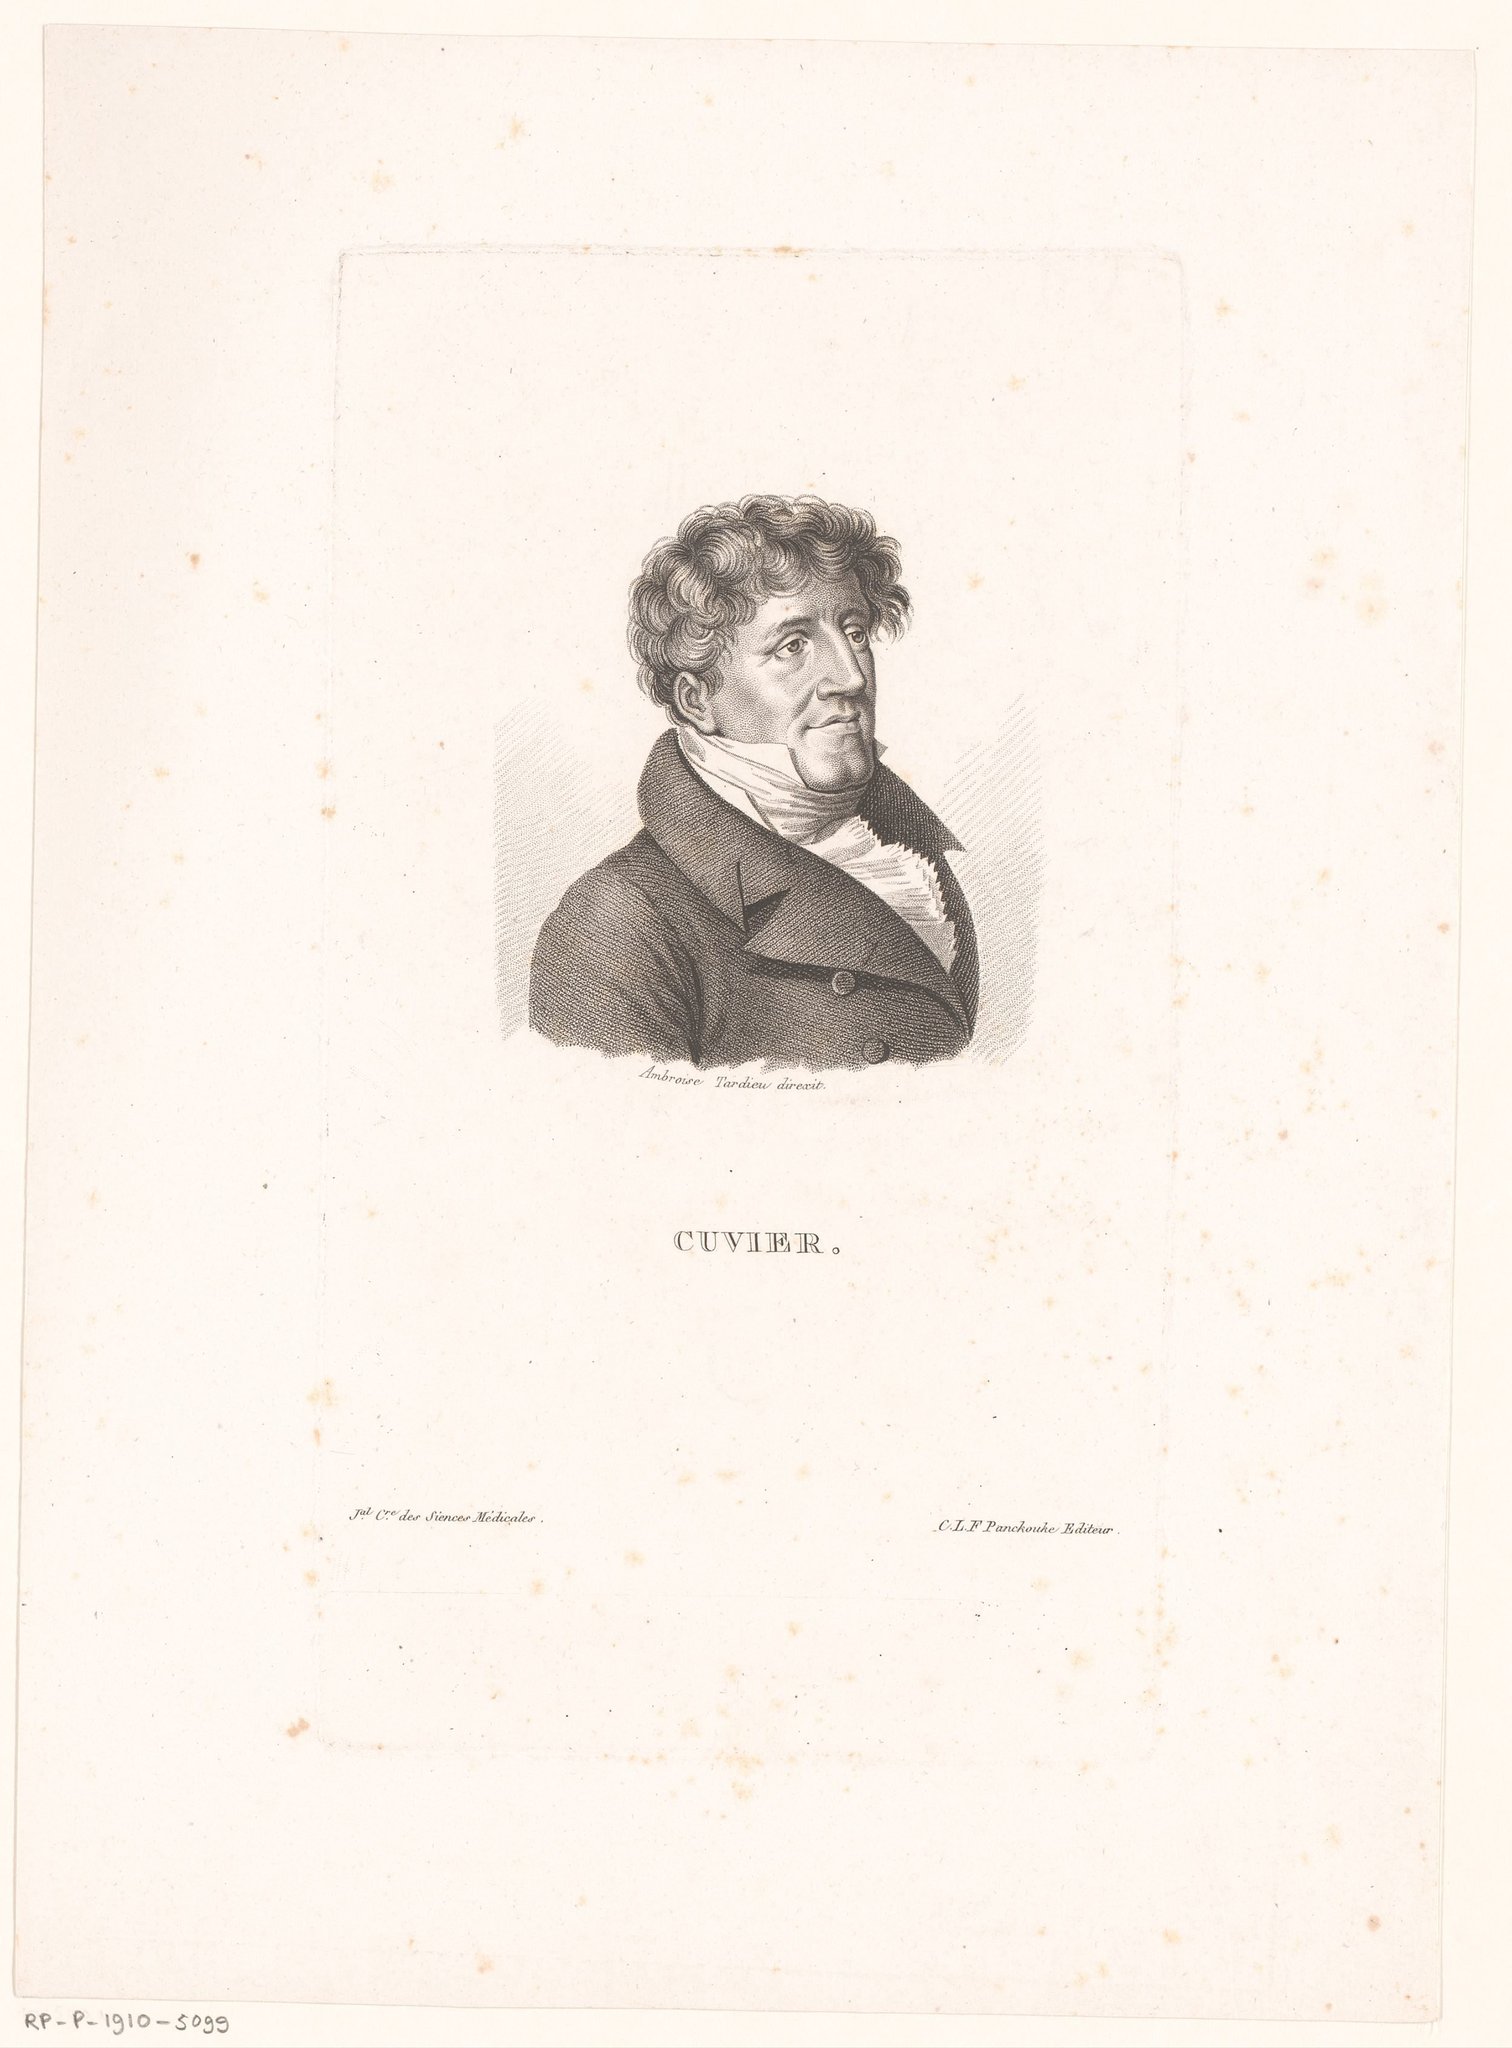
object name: book illustration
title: Portret van Georges Cuvier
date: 1818-1832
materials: paper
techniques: engraving, roulette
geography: paris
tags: paris, scholar, philosopher, historical persons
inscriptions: collector's mark: Lugt 2228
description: Prent uit: Journal complémentaire du Dictionnaire des sciences médicales. Parijs: Panckoucke, Charles Louis Fleury, 1818-1832.